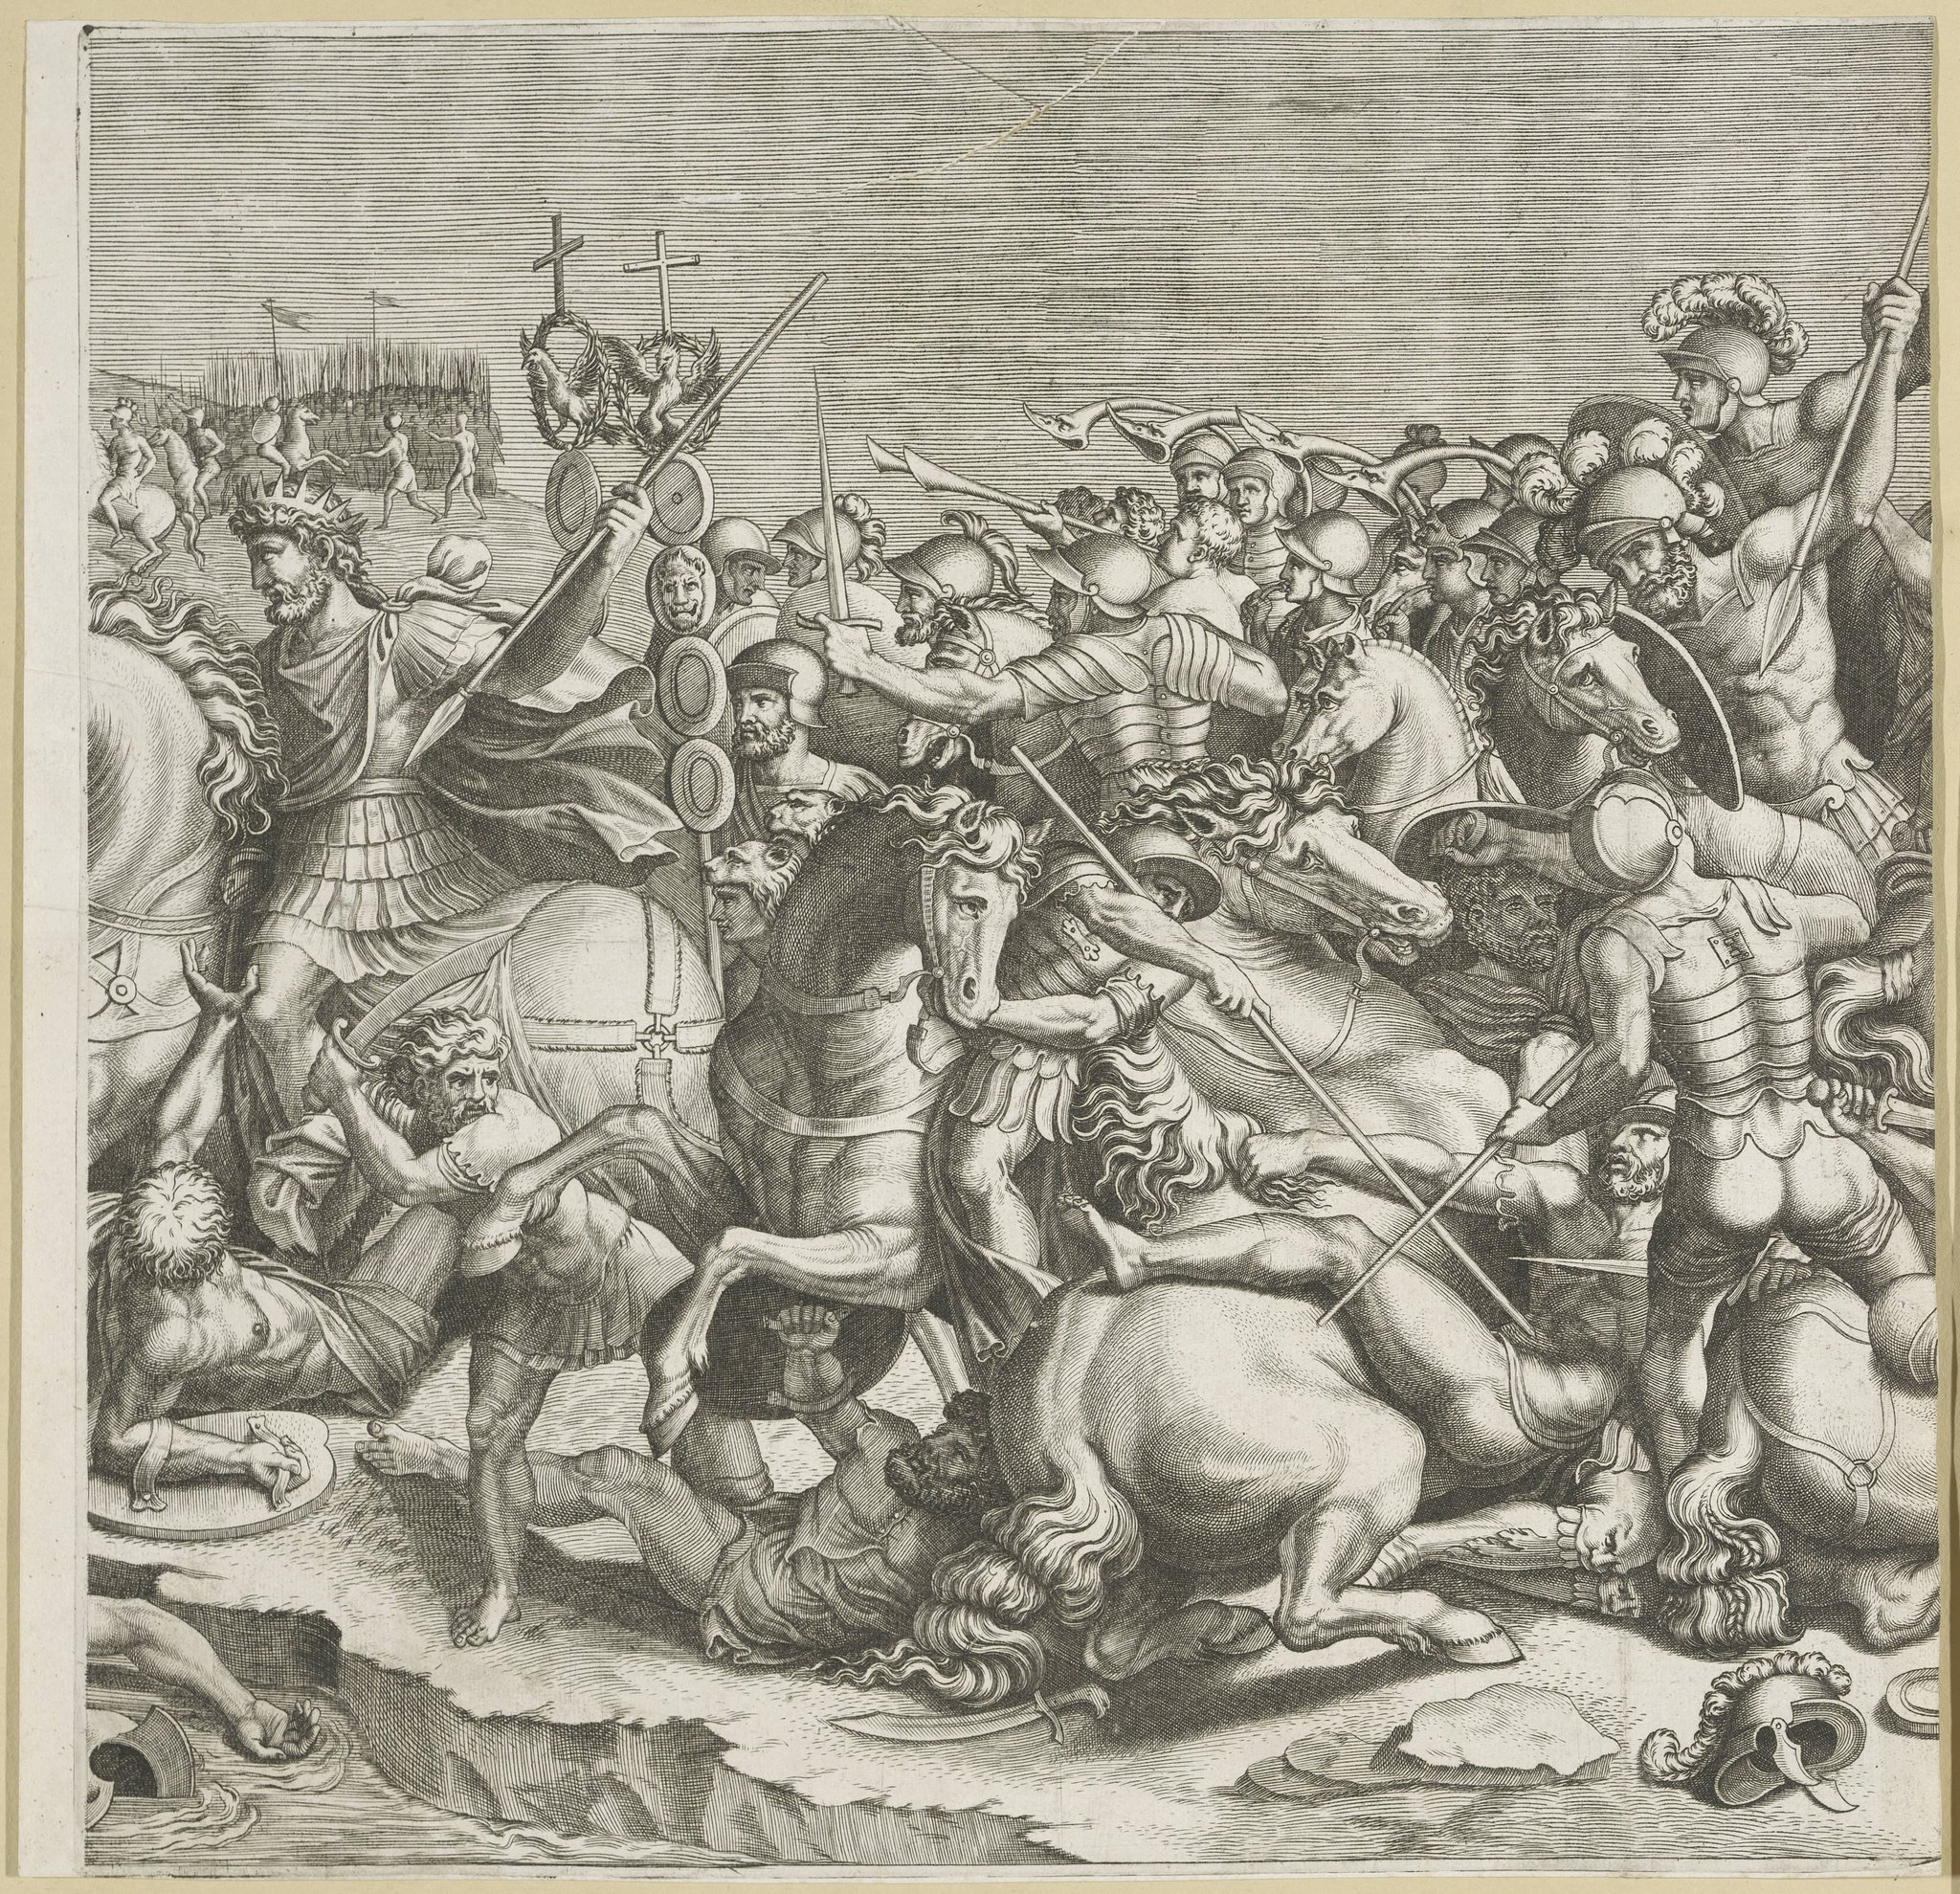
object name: print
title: Slag bij de Milvische brug (rechter middenblad)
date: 1500-1599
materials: paper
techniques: engraving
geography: vatican city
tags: the battle of the milvian bridge (saxa rubra): st. constantine on horseback confronts maxentius; a cross appears in the sky with in fiery letters 'in hoc signo vinces' (the raised standards of the roman soldiers carry a cross or the chi-rho monogram), warfare; military affairs (+ cavalry, horsemen), the soldier; the soldier's life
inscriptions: collector's mark: Lugt 10, collector's mark: Lugt 11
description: Gevechtsscène in een landschap: slag bij de Milvische brug. De soldaten van Constantijn in gevecht met de soldaten van Maxentius. Dode lichamen liggen op de grond. Soldaten te paard verdrinken in de rivier.